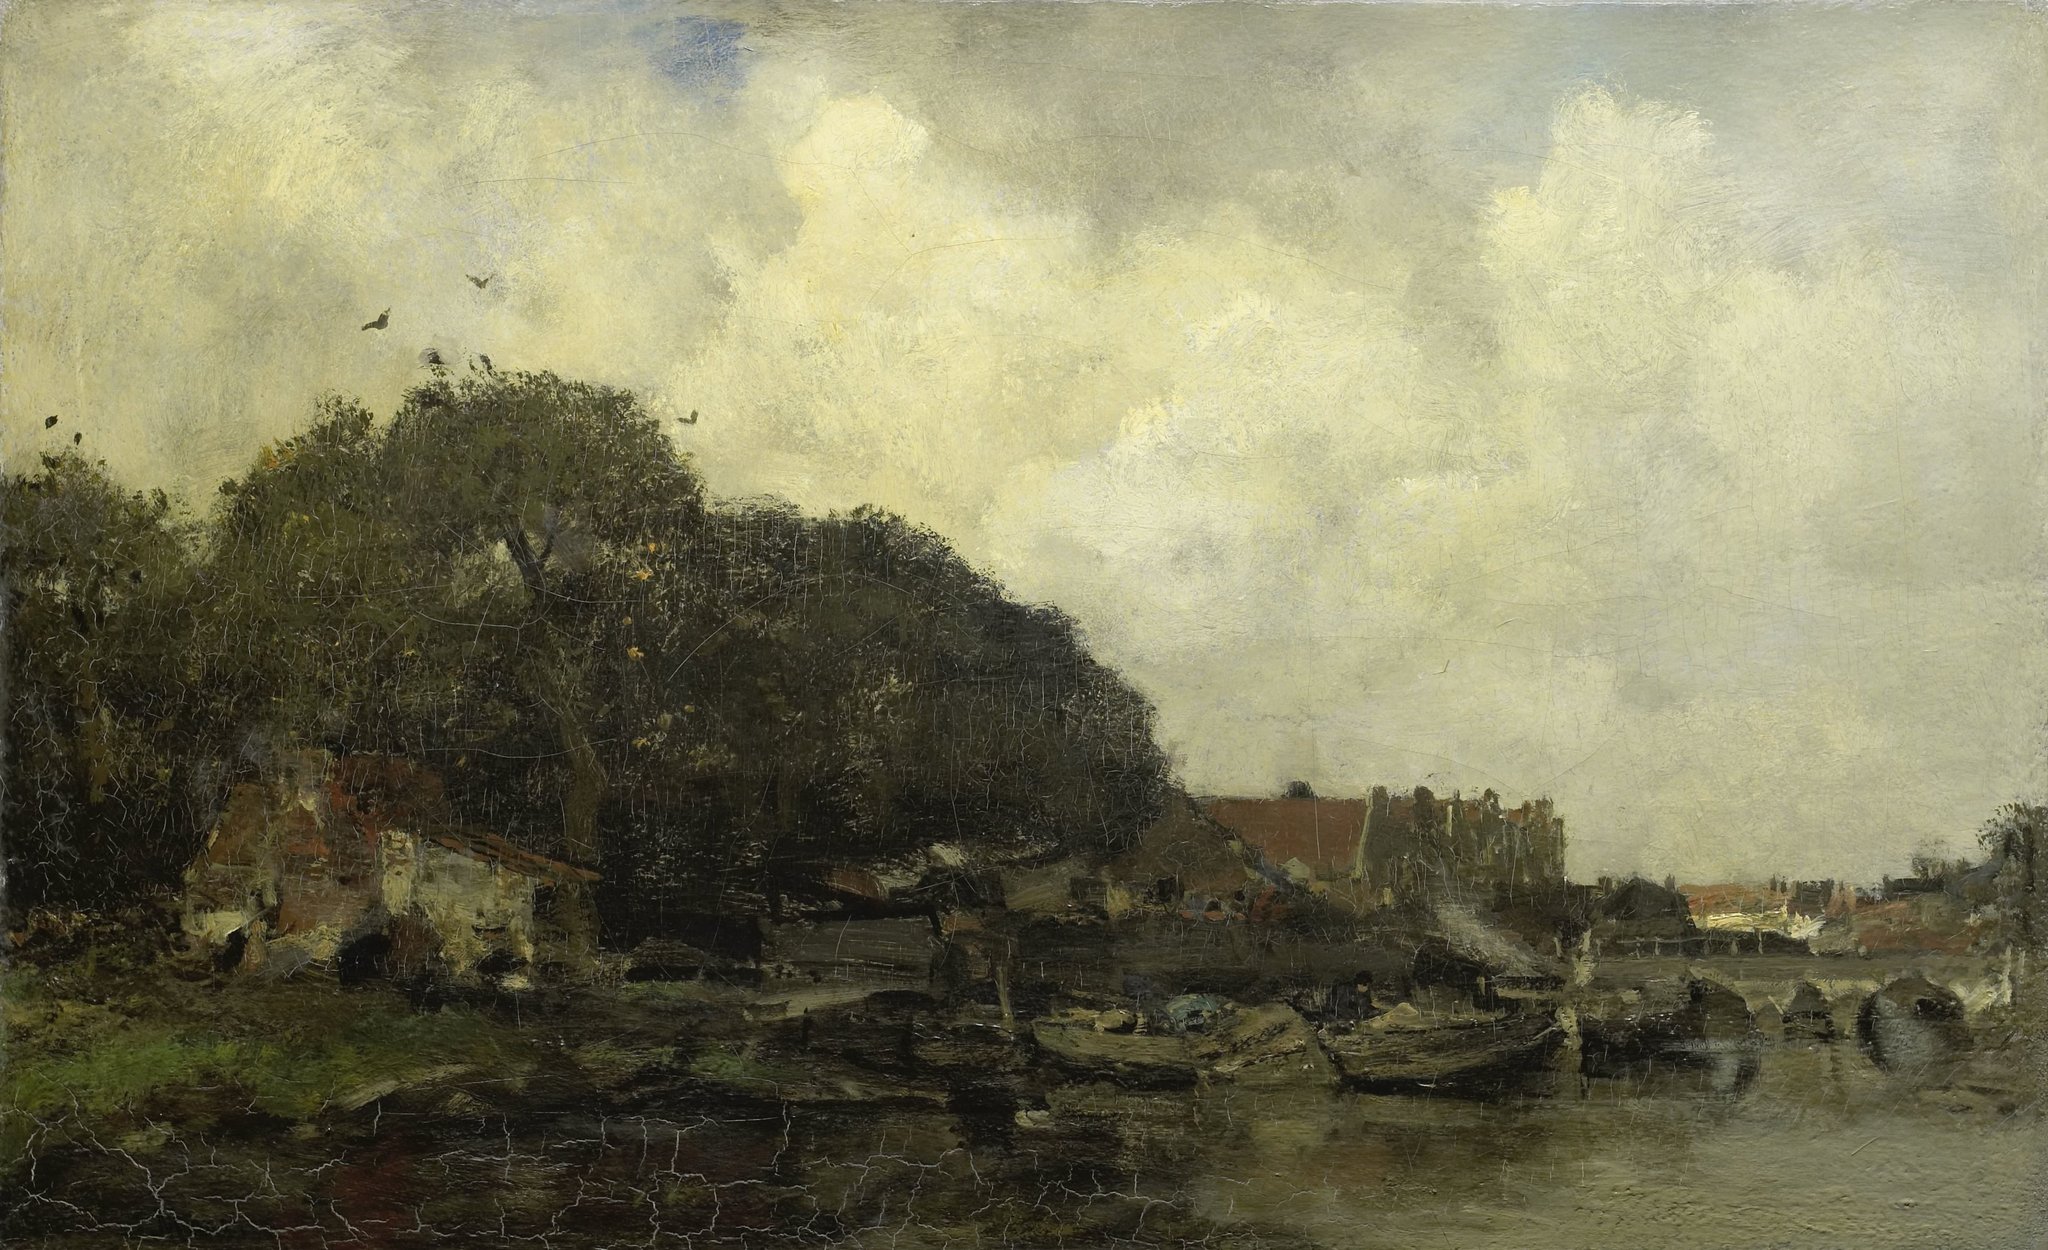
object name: painting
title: Havengezicht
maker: jacob maris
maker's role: draughtsman, painter, print maker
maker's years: 1837-1899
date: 1870-1899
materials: canvas, oil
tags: harbour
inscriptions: signature: ‘J. Maris’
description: Havengezicht. Gezicht op een rivier met links huizen onder geboomte en een werf met schuiten in het water. Rechts in de verte een stenen brug met bogen.